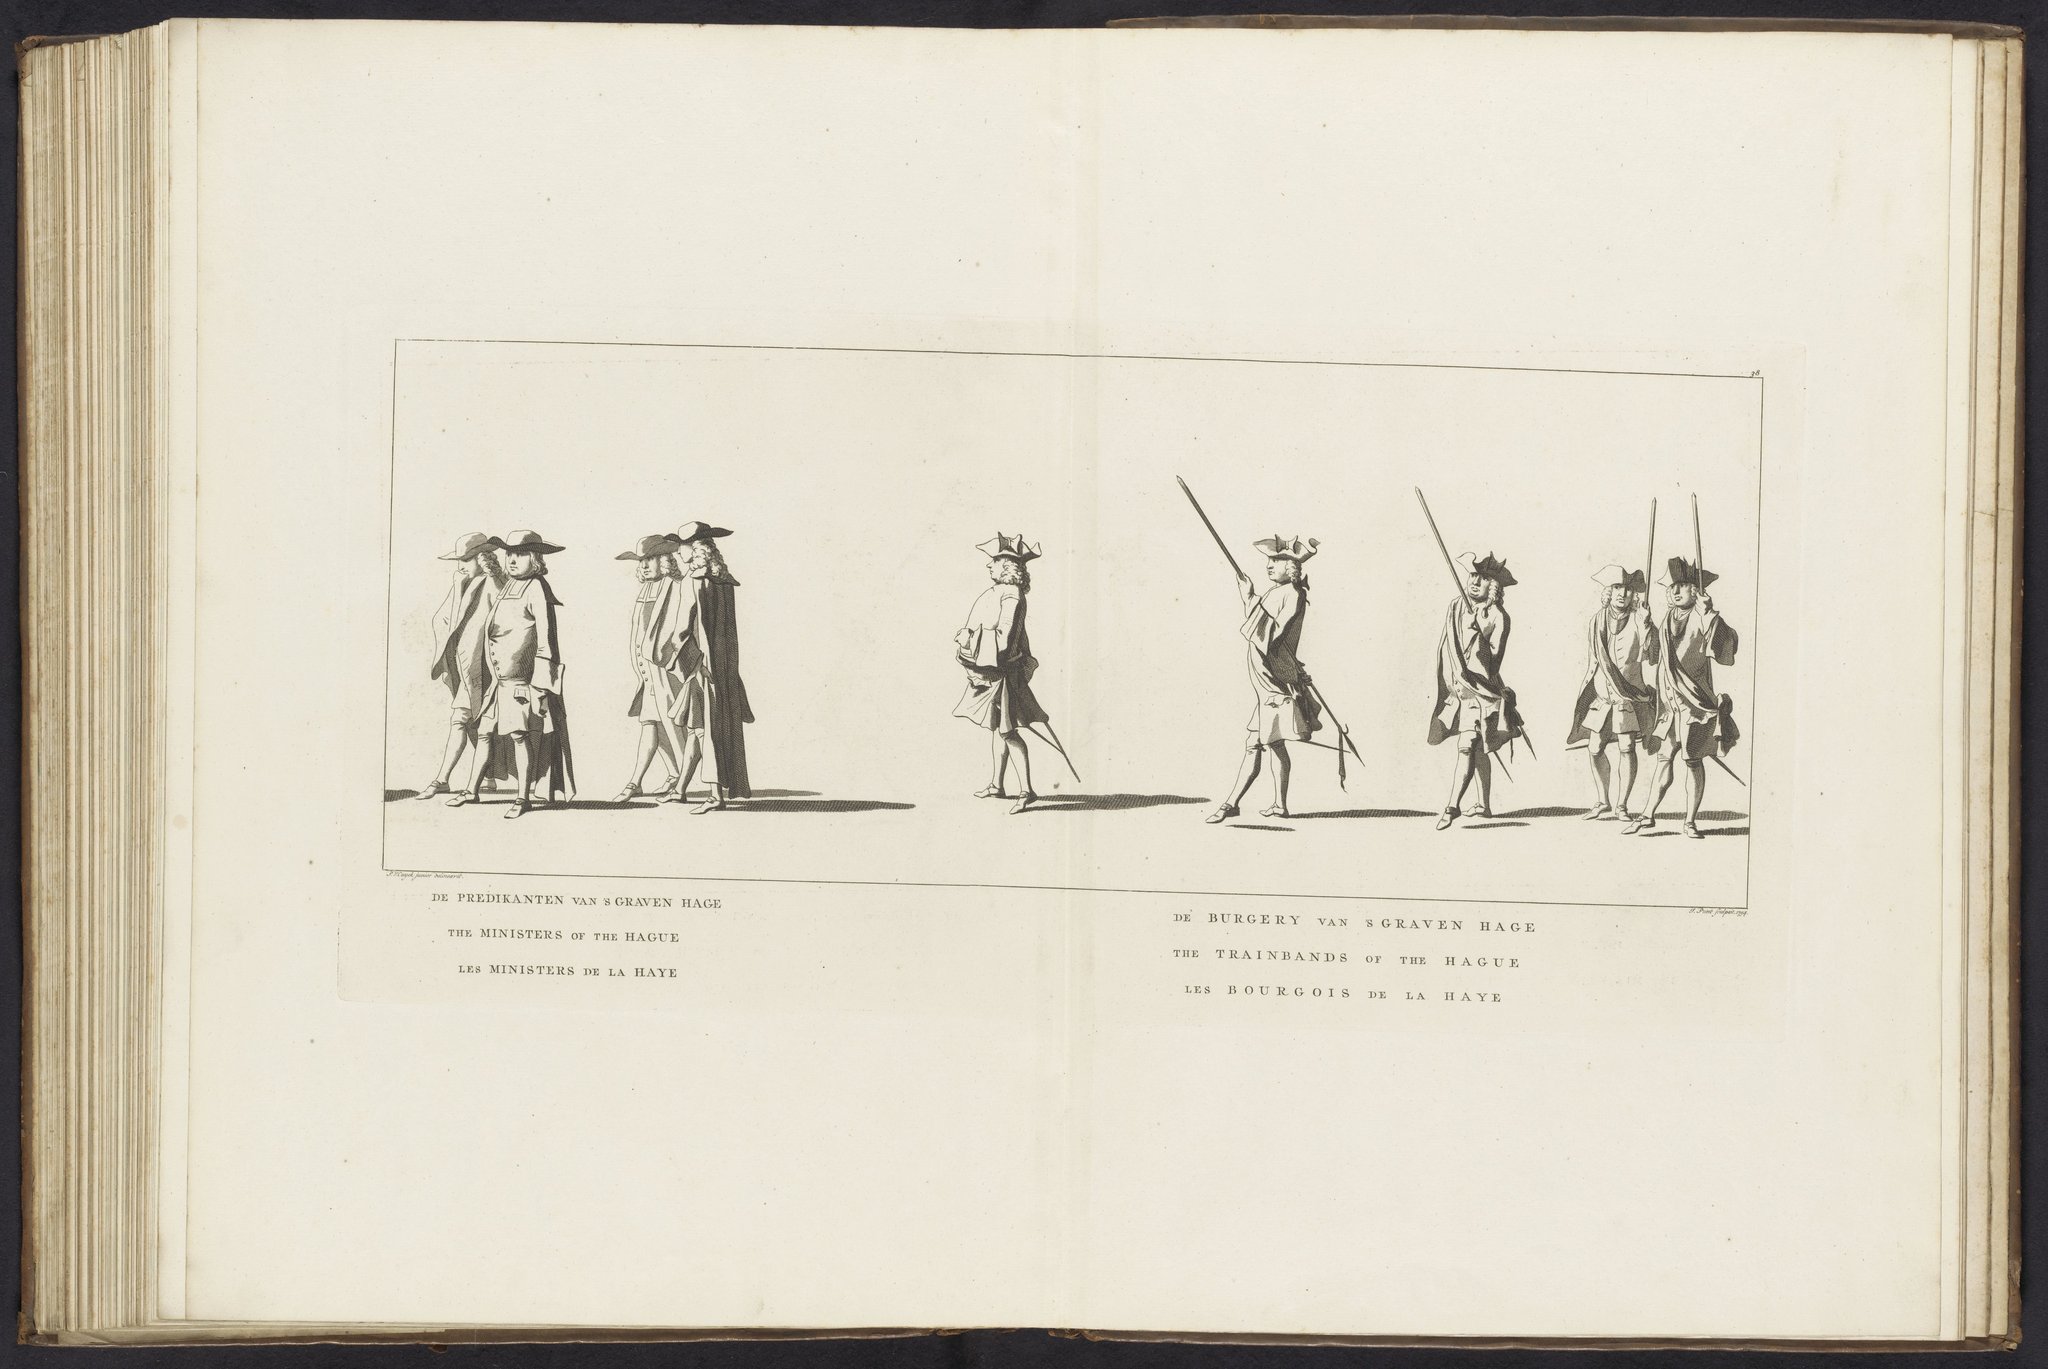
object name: print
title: De Predikanten van 's Graven Hage / De Burgery van 's Graven Hage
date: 1754-1755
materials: paper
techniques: engraving, etching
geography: the hague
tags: willem iv (prins van oranje-nassau), cortege, funeral procession, functionaries and dignitaries ~ protestant churches, delft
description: Predikanten en vertegenwoordigers van de burgerij van Den Haag. In de marge het onderschrift in Nederlands, Frans en Engels. Onderdeel van een serie van 41 platen van de begrafenisstoet van stadhouder Willem IV te Delft op 4 februari 1752. Genummerd rechtsboven: 38. In de gebonden uitgave van 1755.